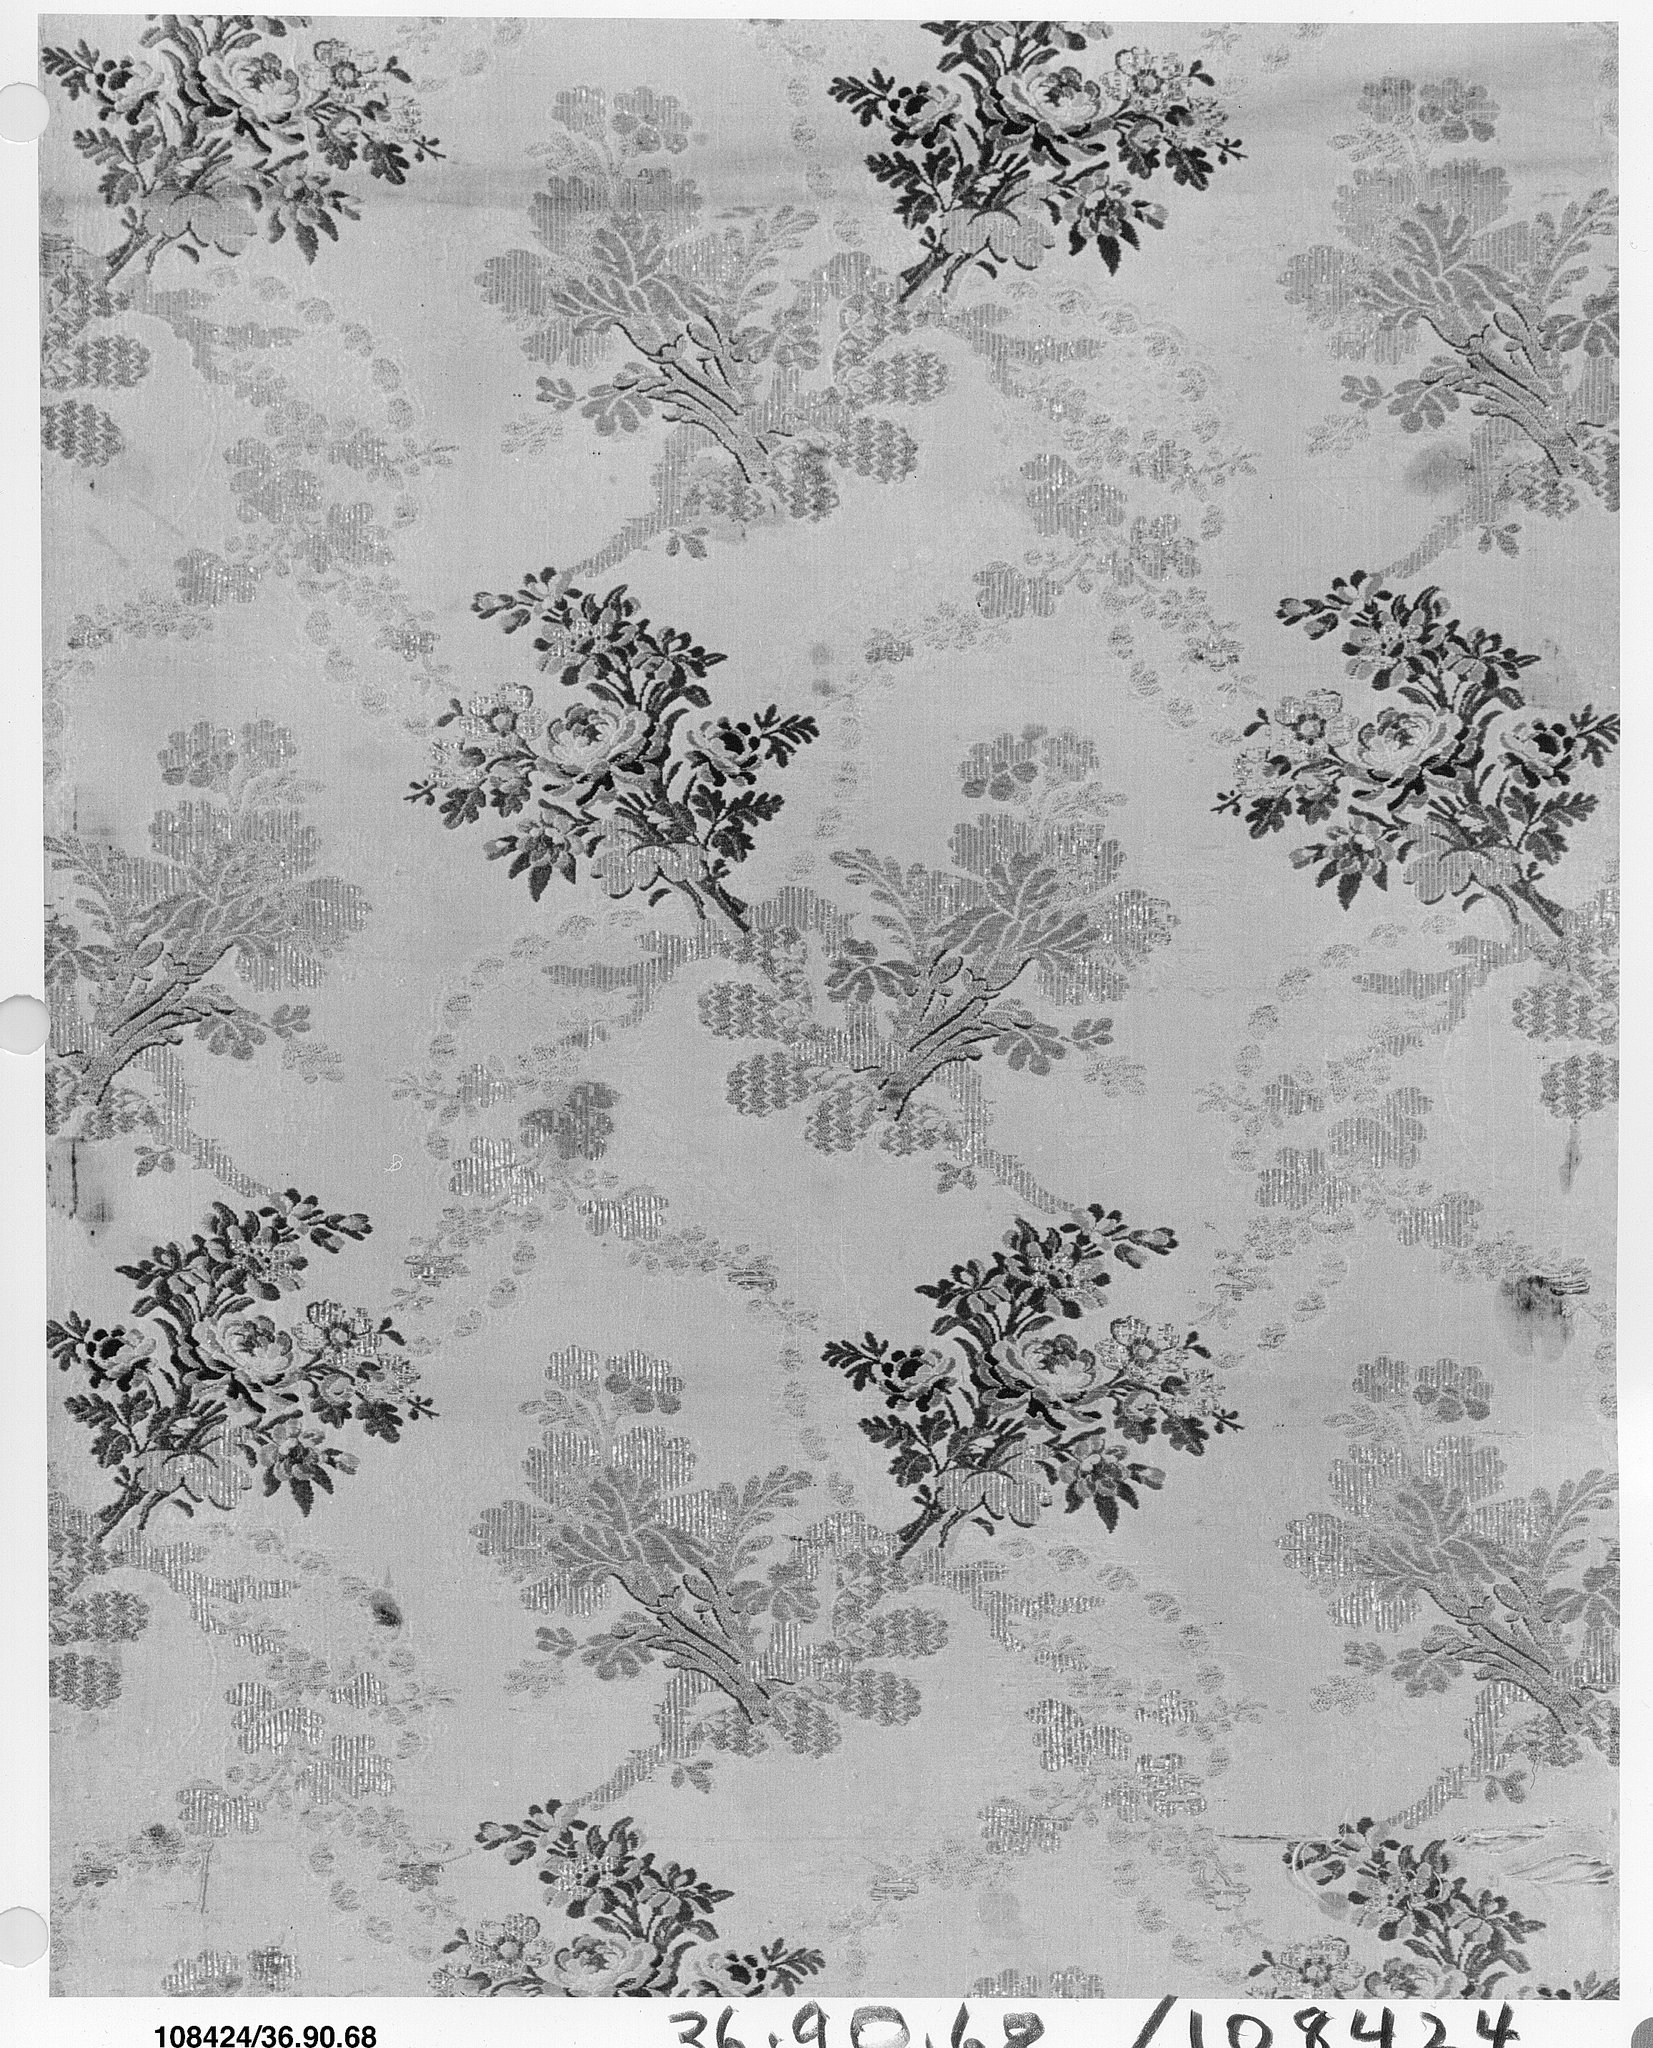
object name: piece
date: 1734-1766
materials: metal thread, silk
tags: flowers,leaves